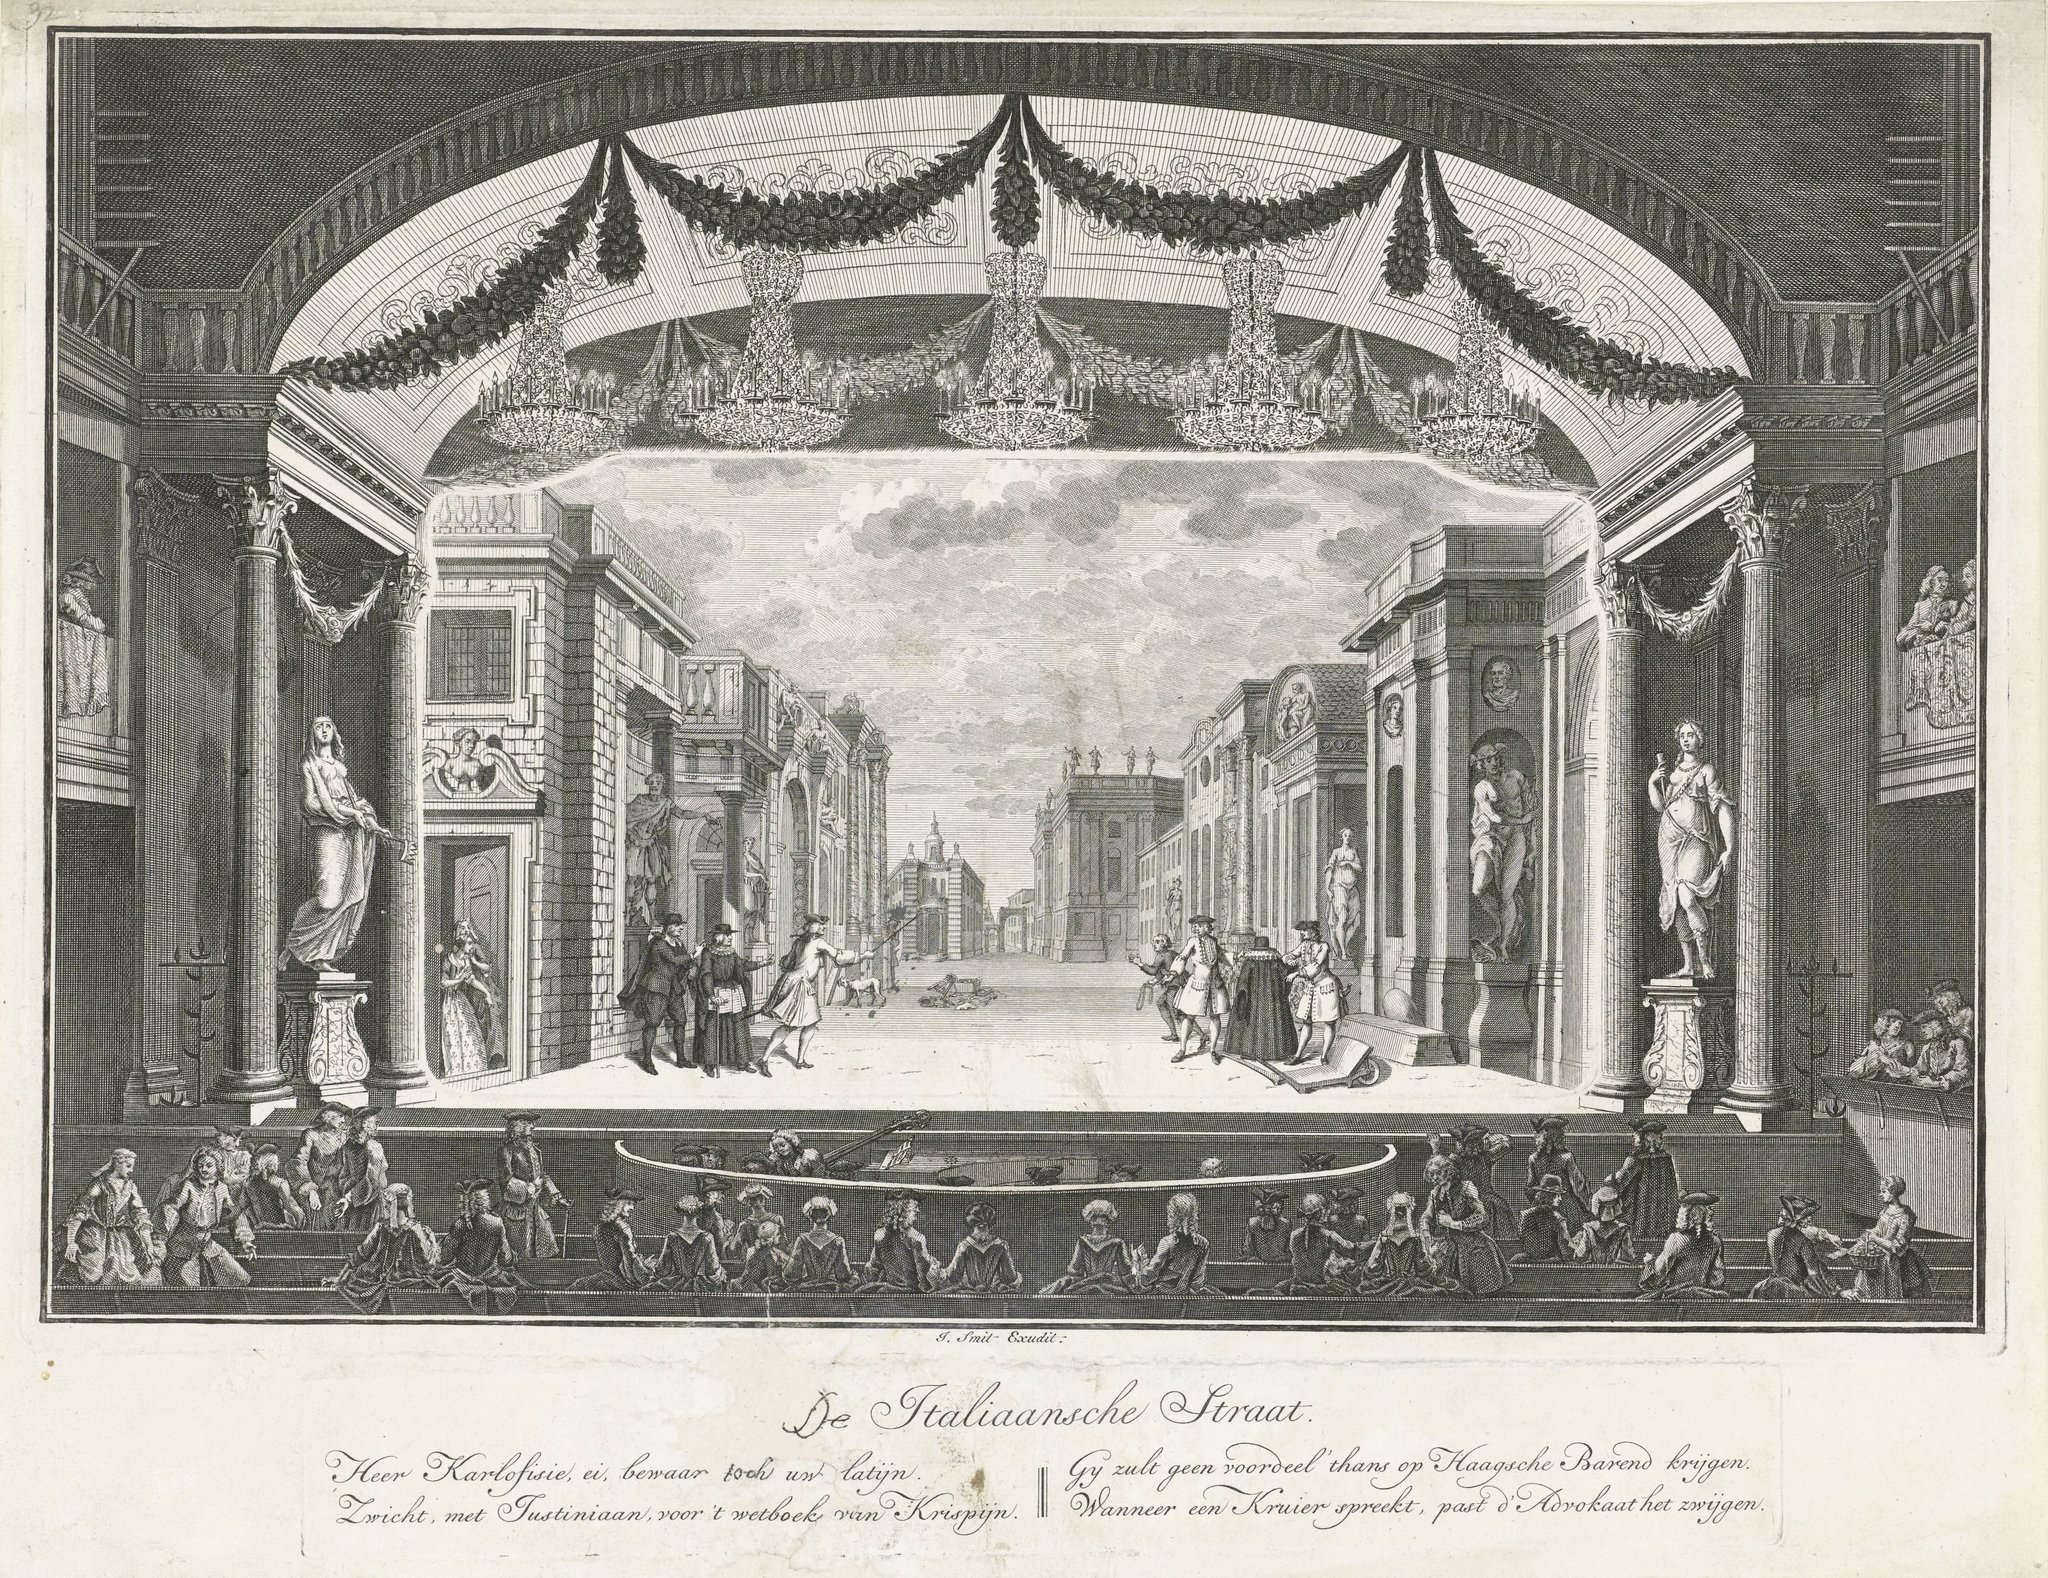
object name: print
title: Schouwburg met toneeldecor: De Italiaansche Straat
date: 1736-1738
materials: paper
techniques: engraving, etching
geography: amsterdam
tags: theatre, theatrical performance, stage design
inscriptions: collector's mark: Lugt 2228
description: Toneelvoorstelling in de Amsterdamse Schouwburg op de Keizersgracht met het coulissendecor De Italiaansche Straat met scène uit: De Gewaande Advocaat. Het decor gedrukt van een aparte plaat binnen een passe-partout met de zaal, zijloges, orkestbak en de façade van het toneel met zuilen, guirlandes en kroonluchters. De titel en een vierregelig vers ook gedrukt van een aparte plaat. Onderdeel van een serie van 12 toneeldecors.